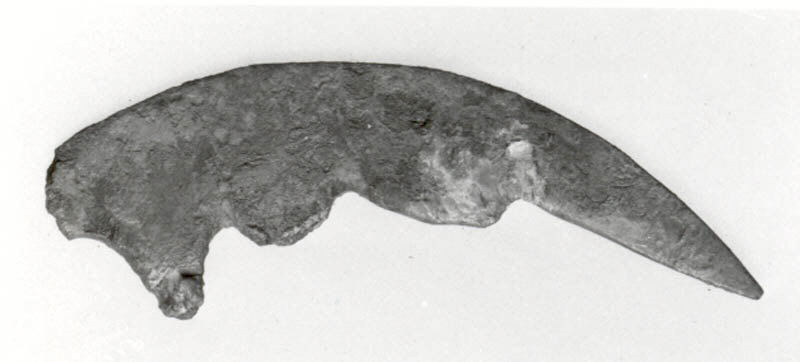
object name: tool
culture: iranian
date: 5000-2001 BCE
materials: copper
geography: iran